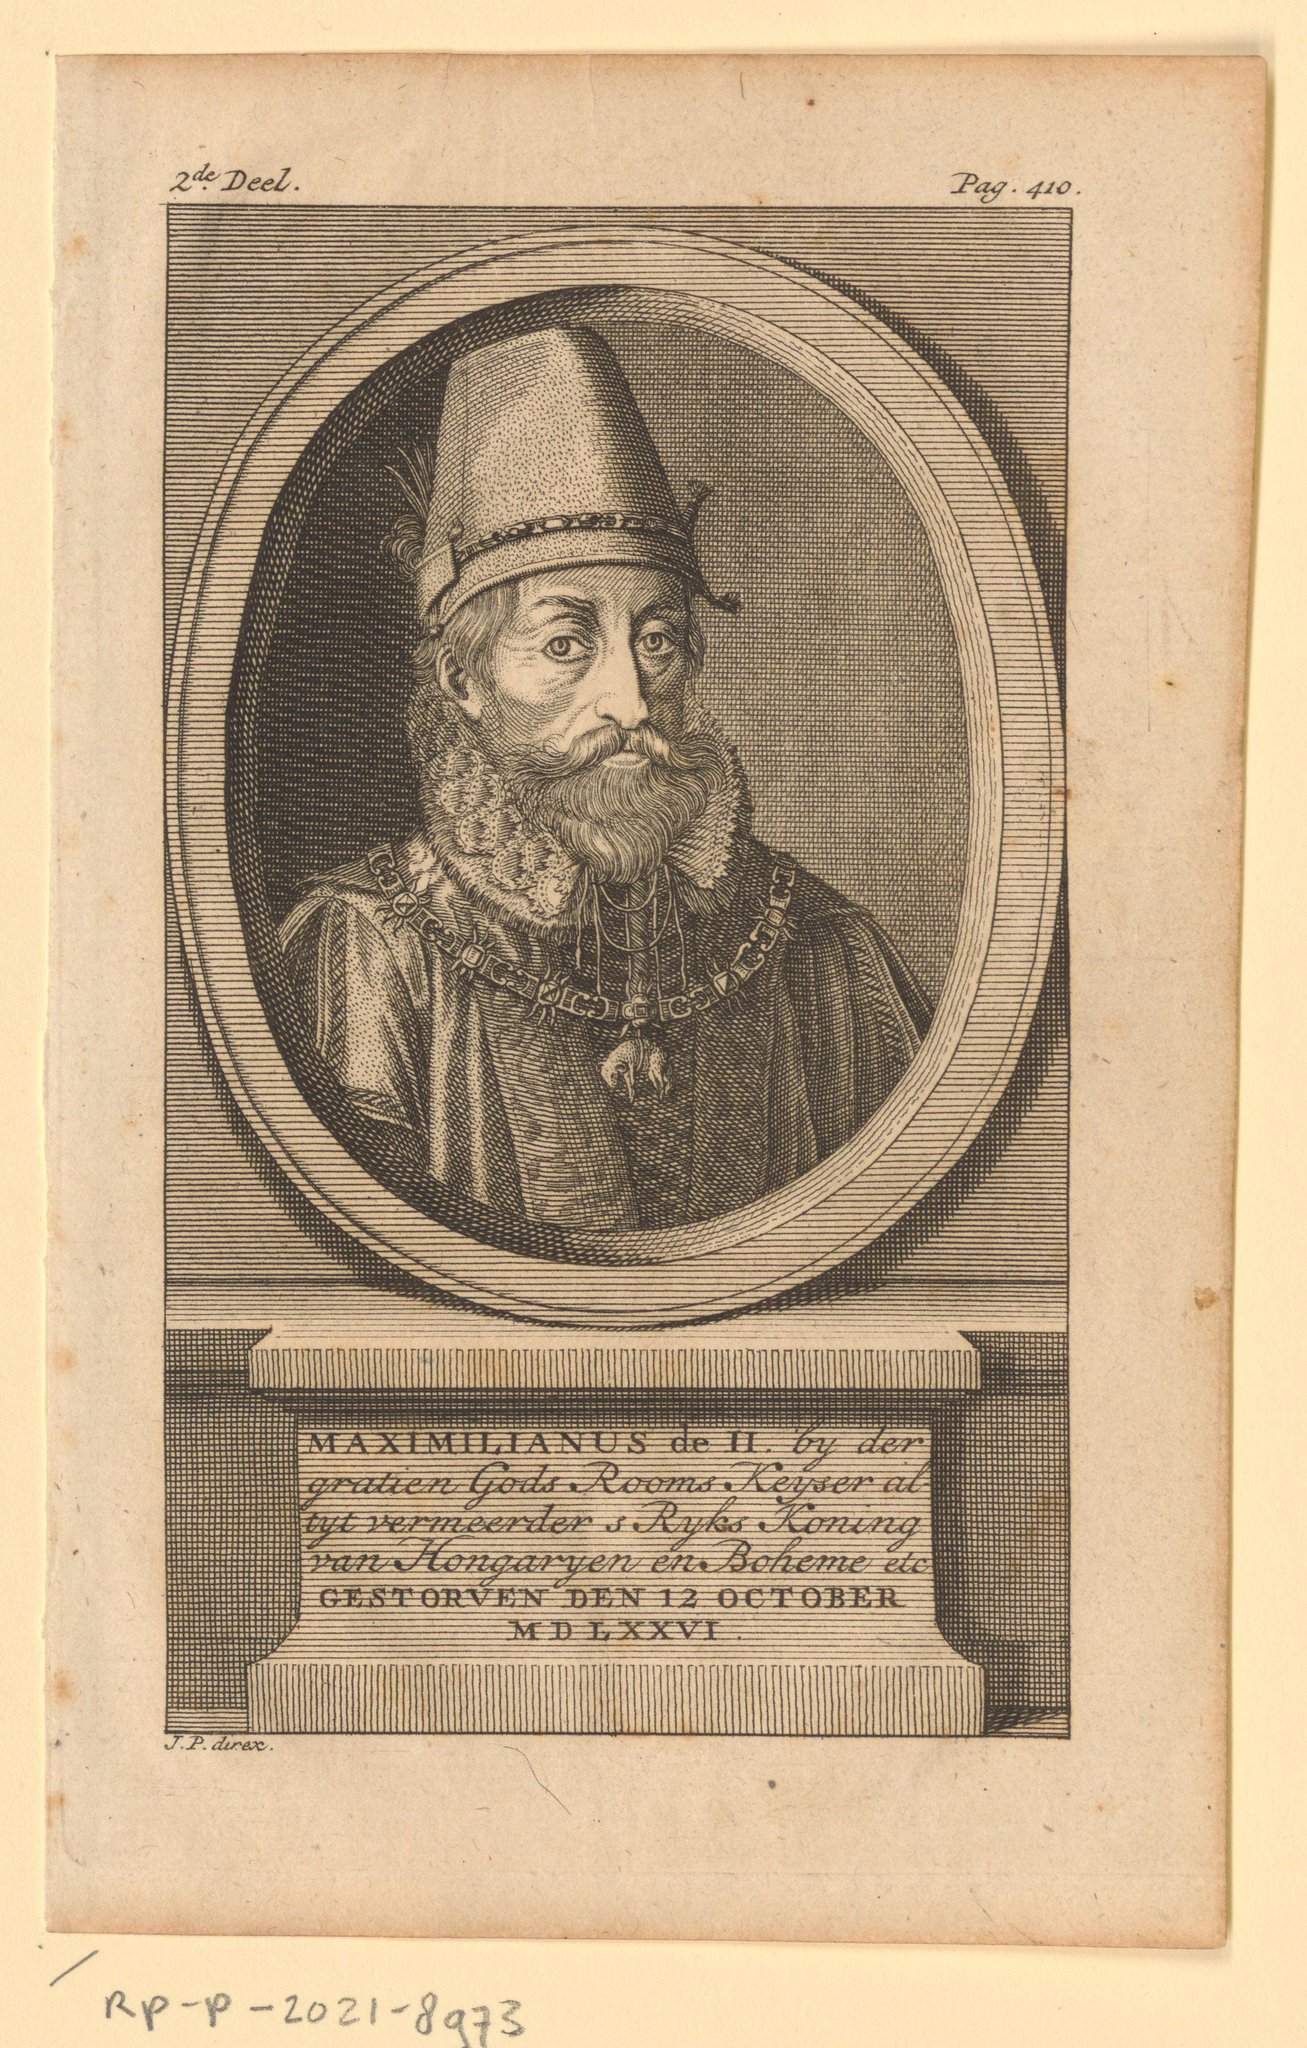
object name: print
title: Portret van keizer Maximiliaan II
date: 1749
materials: paper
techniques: etching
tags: vienna, maximiliaan ii (keizer van heilige roomse rijk), ornament ~ medallion, historical persons, knighthood order of the golden fleece - insignia of a knighthood order, e.g.: badge, chain (with name of order)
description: Prent waarschijnlijk uit: Meteren, Emanuel van. Historie van de oorlogen en geschiedenissen der Nederlanden (...). Gorinchem: Nicolaas Goetzee, Breda: Willem Goetzee, 1749. Latere staat gebruikt in editie uit 1786.